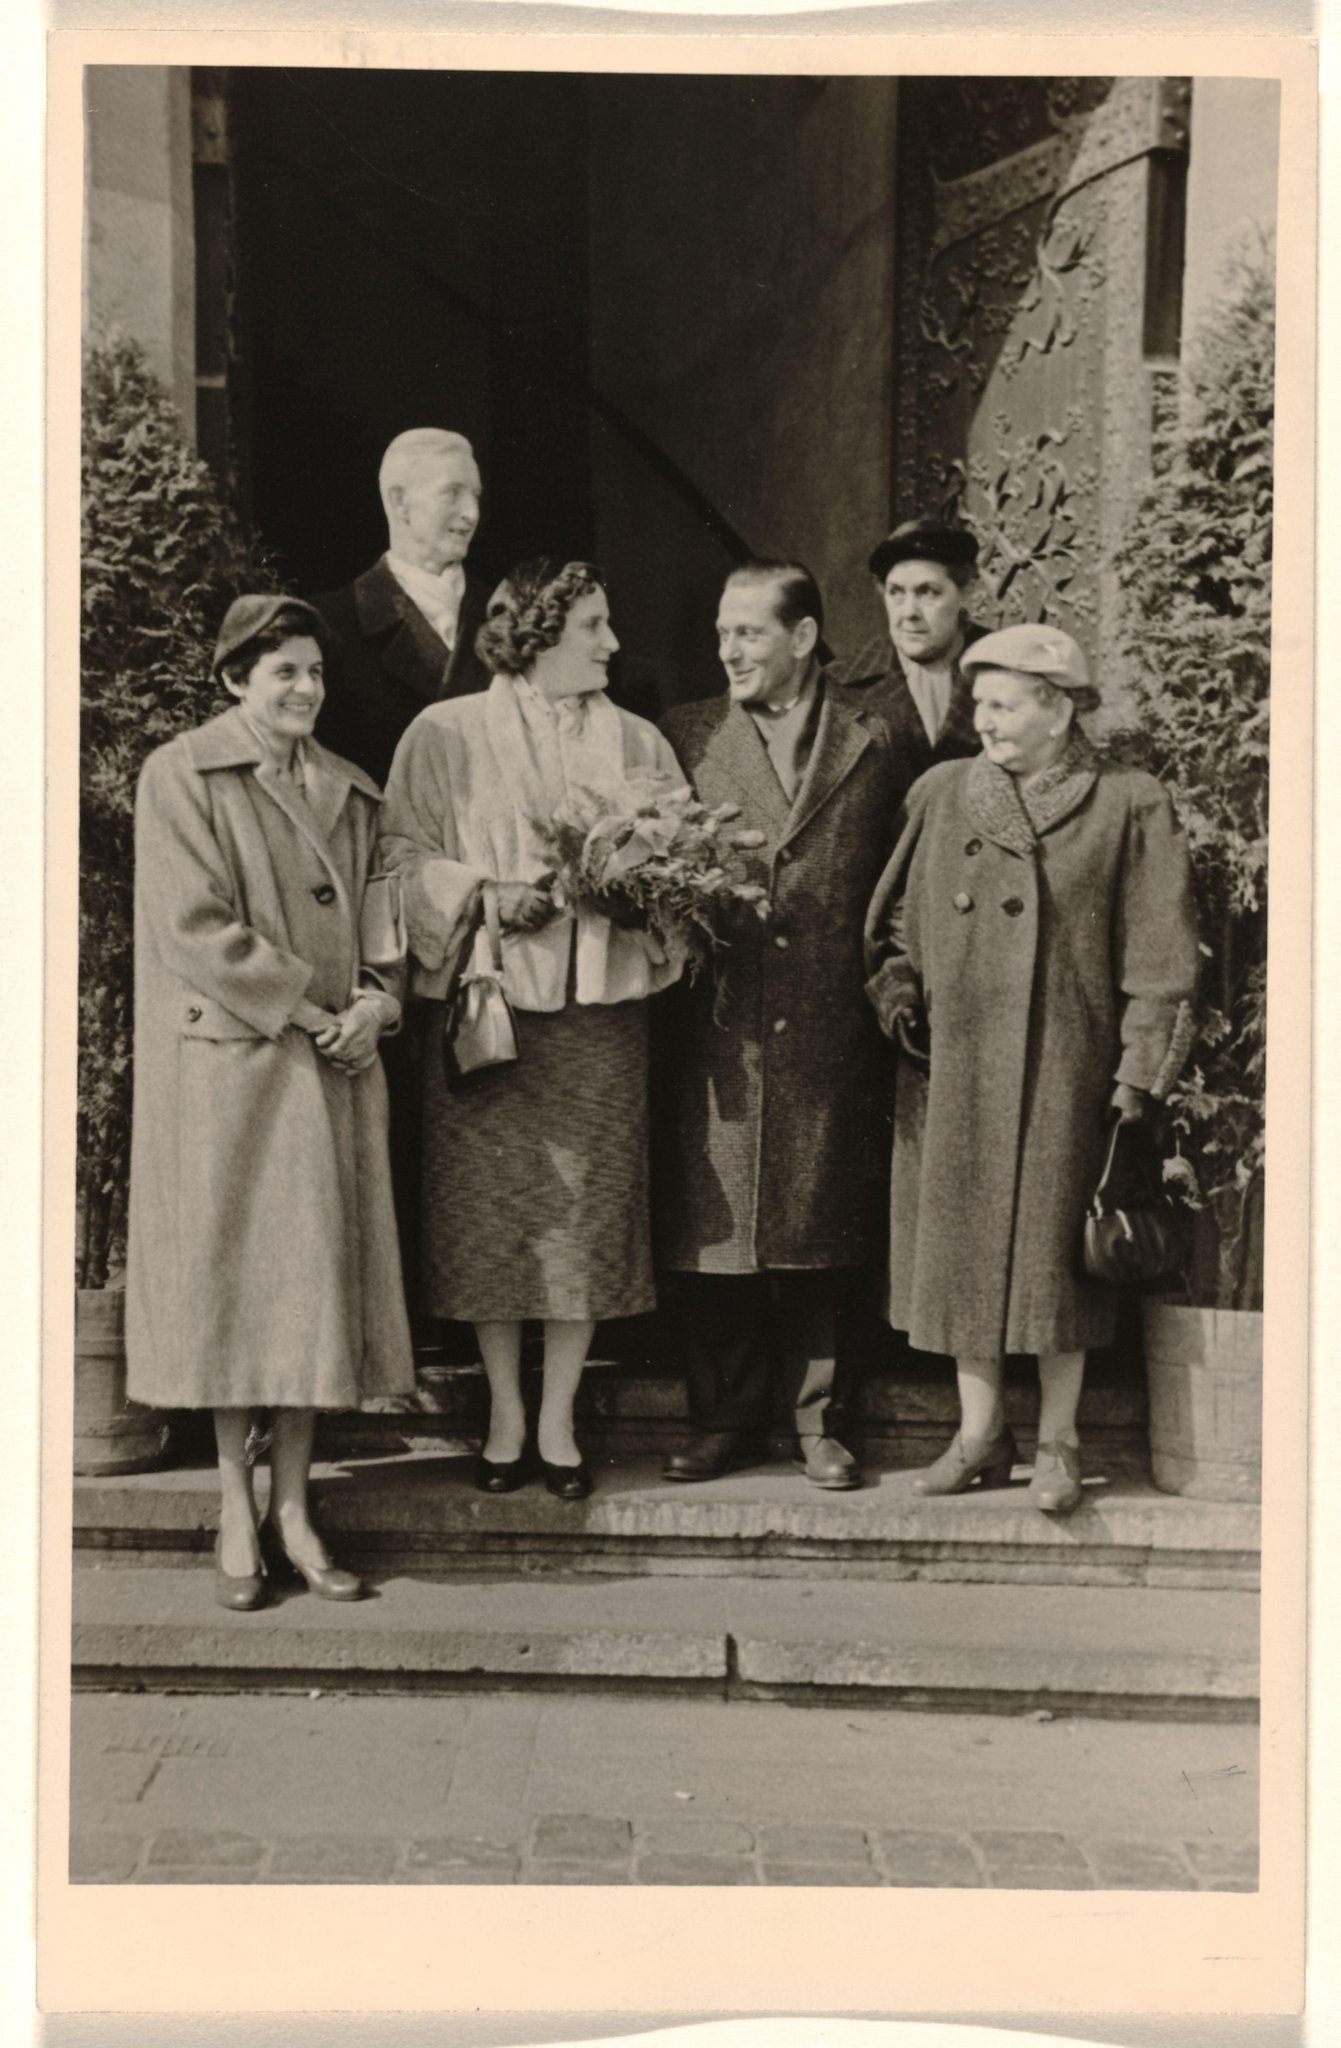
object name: photograph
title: Isabel Wachenheimer en Gideon Elon op hun trouwdag met vier onbekende mensen bij de ingang van een kerk, op 10 maart 1956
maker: Anonymous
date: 1956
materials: photographic support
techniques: gelatin silver print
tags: leiden, isabel wachenheimer-elon, gideon elon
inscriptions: inscription: ‘Unseren treuen klein als Andenken an den 10.3.1956 und an das Schätzlein-Ehepaar’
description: Isabel Wachenheimer (tweede van links) en Gideon Elon (tweede van rechts) op hun trouwdag met vier onbekende mensen bij de ingang van een kerk